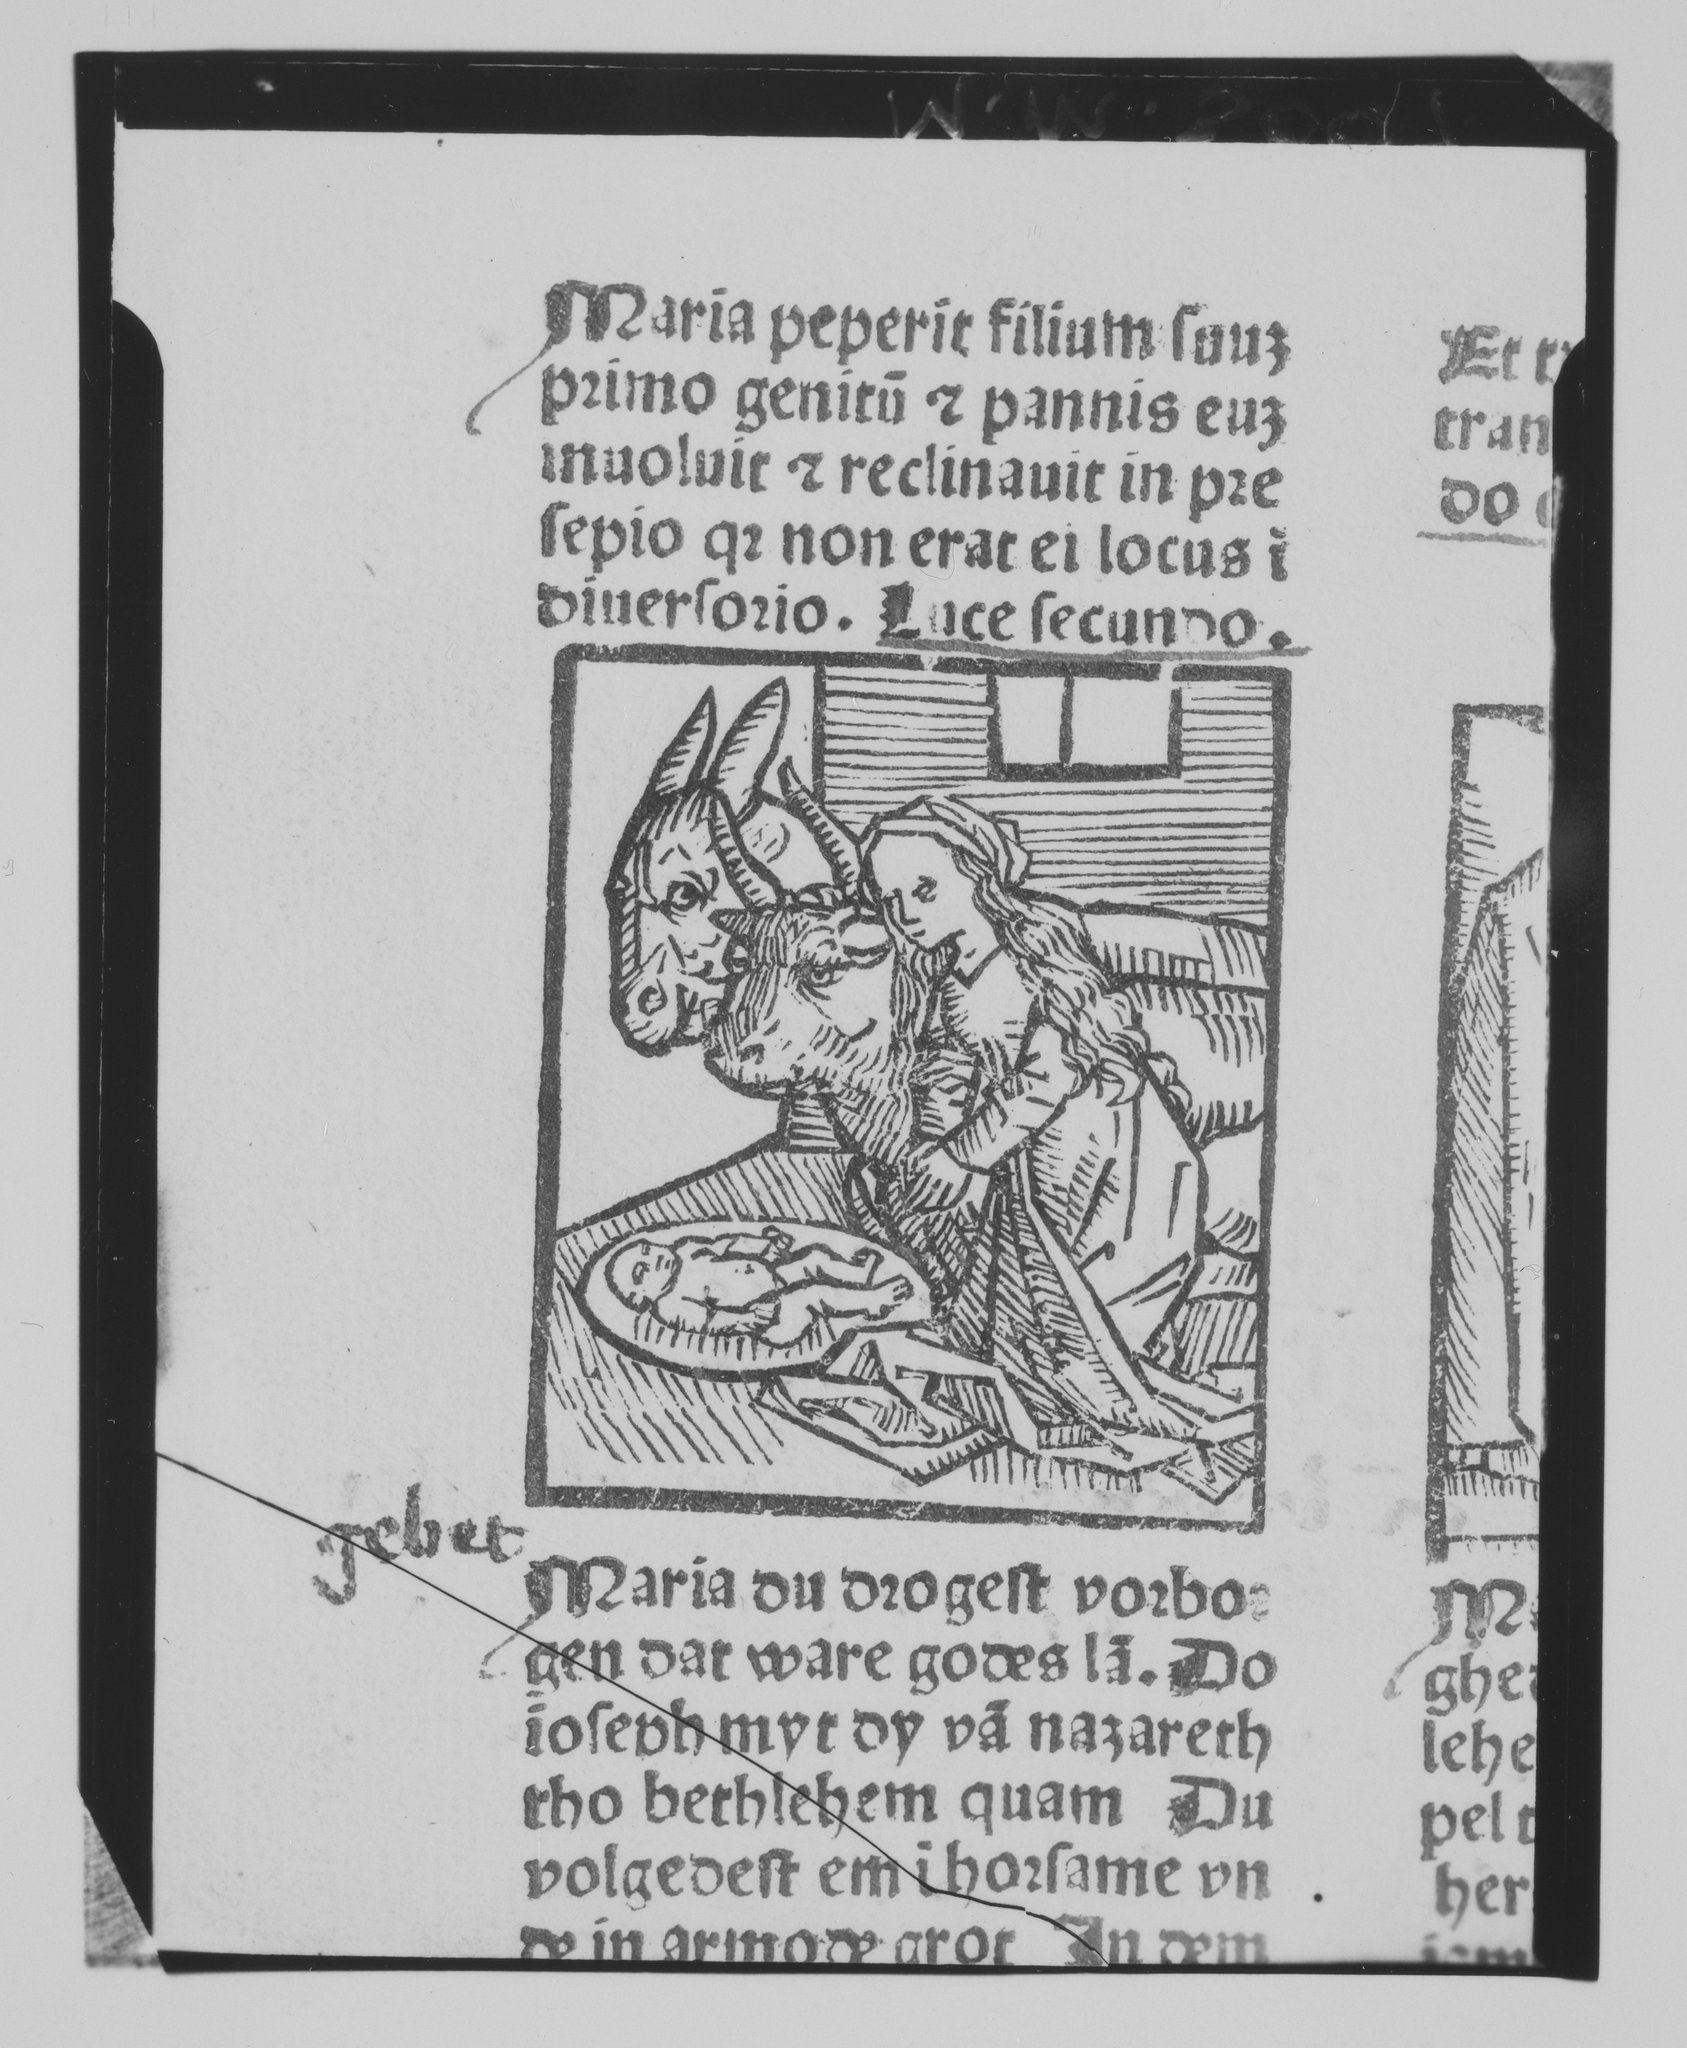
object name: book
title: Dat boek van der navolghinge ihesu Christi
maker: the poppy printer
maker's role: printer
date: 1489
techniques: woodcut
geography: germany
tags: animals,women